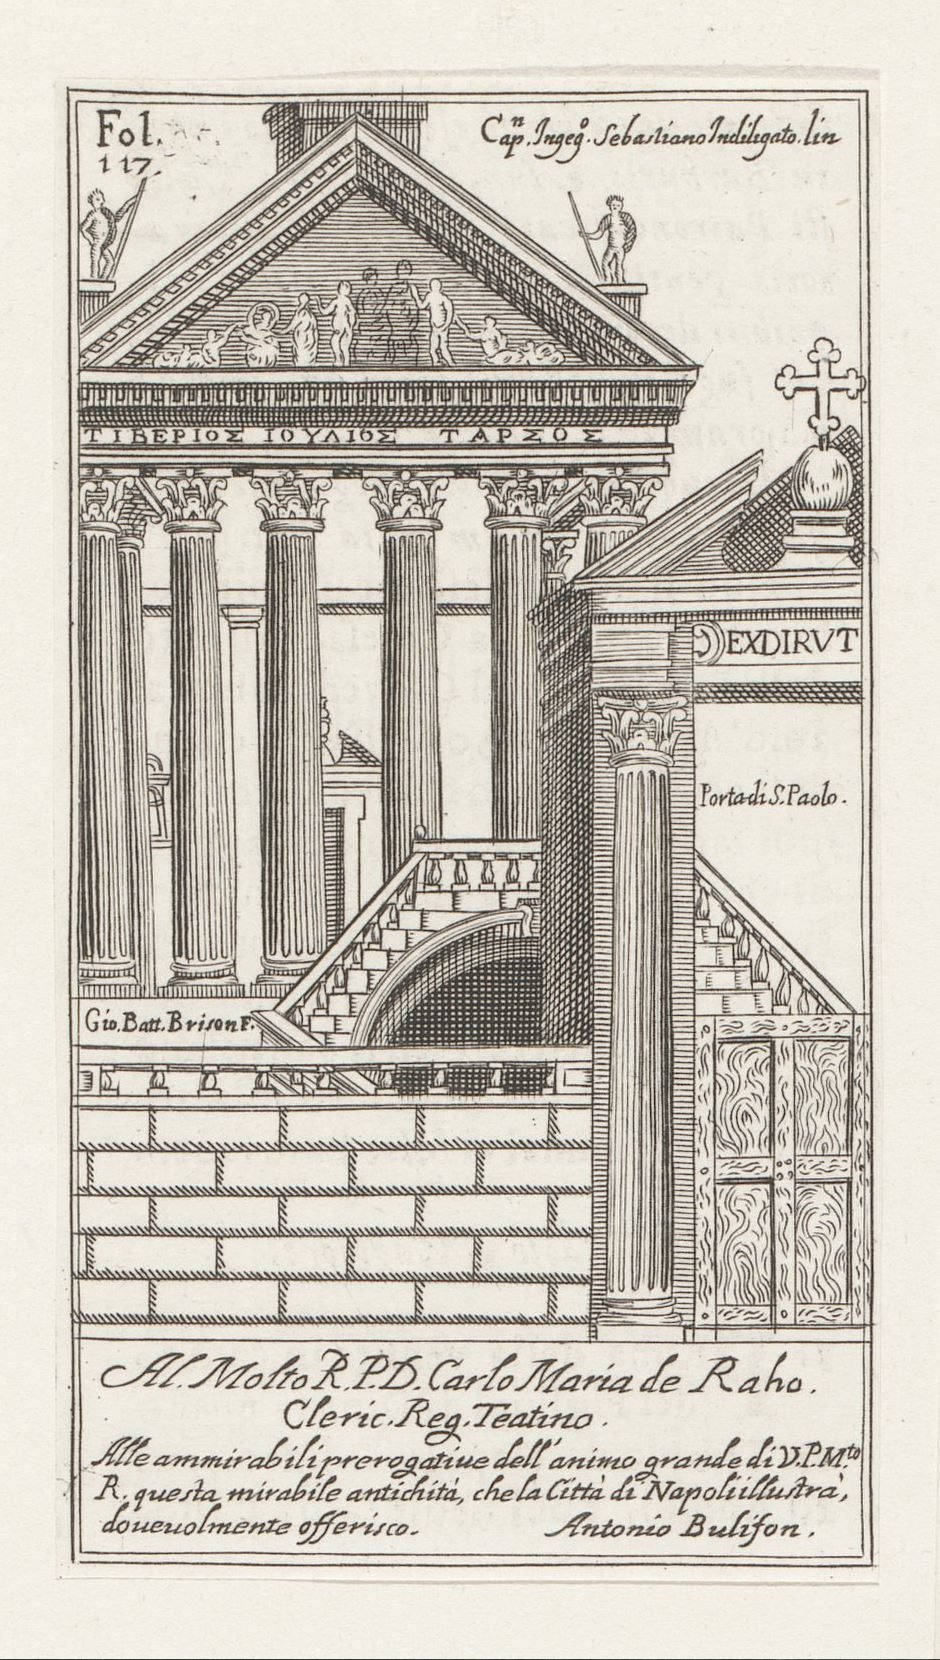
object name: print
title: Tempelfaçade, balustrade en de Porta di San Paolo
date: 1659-1707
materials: paper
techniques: etching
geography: italy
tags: balustrade, temple, shrine ~ roman religion, city-gate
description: Genummerd linksboven: Fol. 117. Opdracht in ondermarge. De prent maakt deel uit van een album.